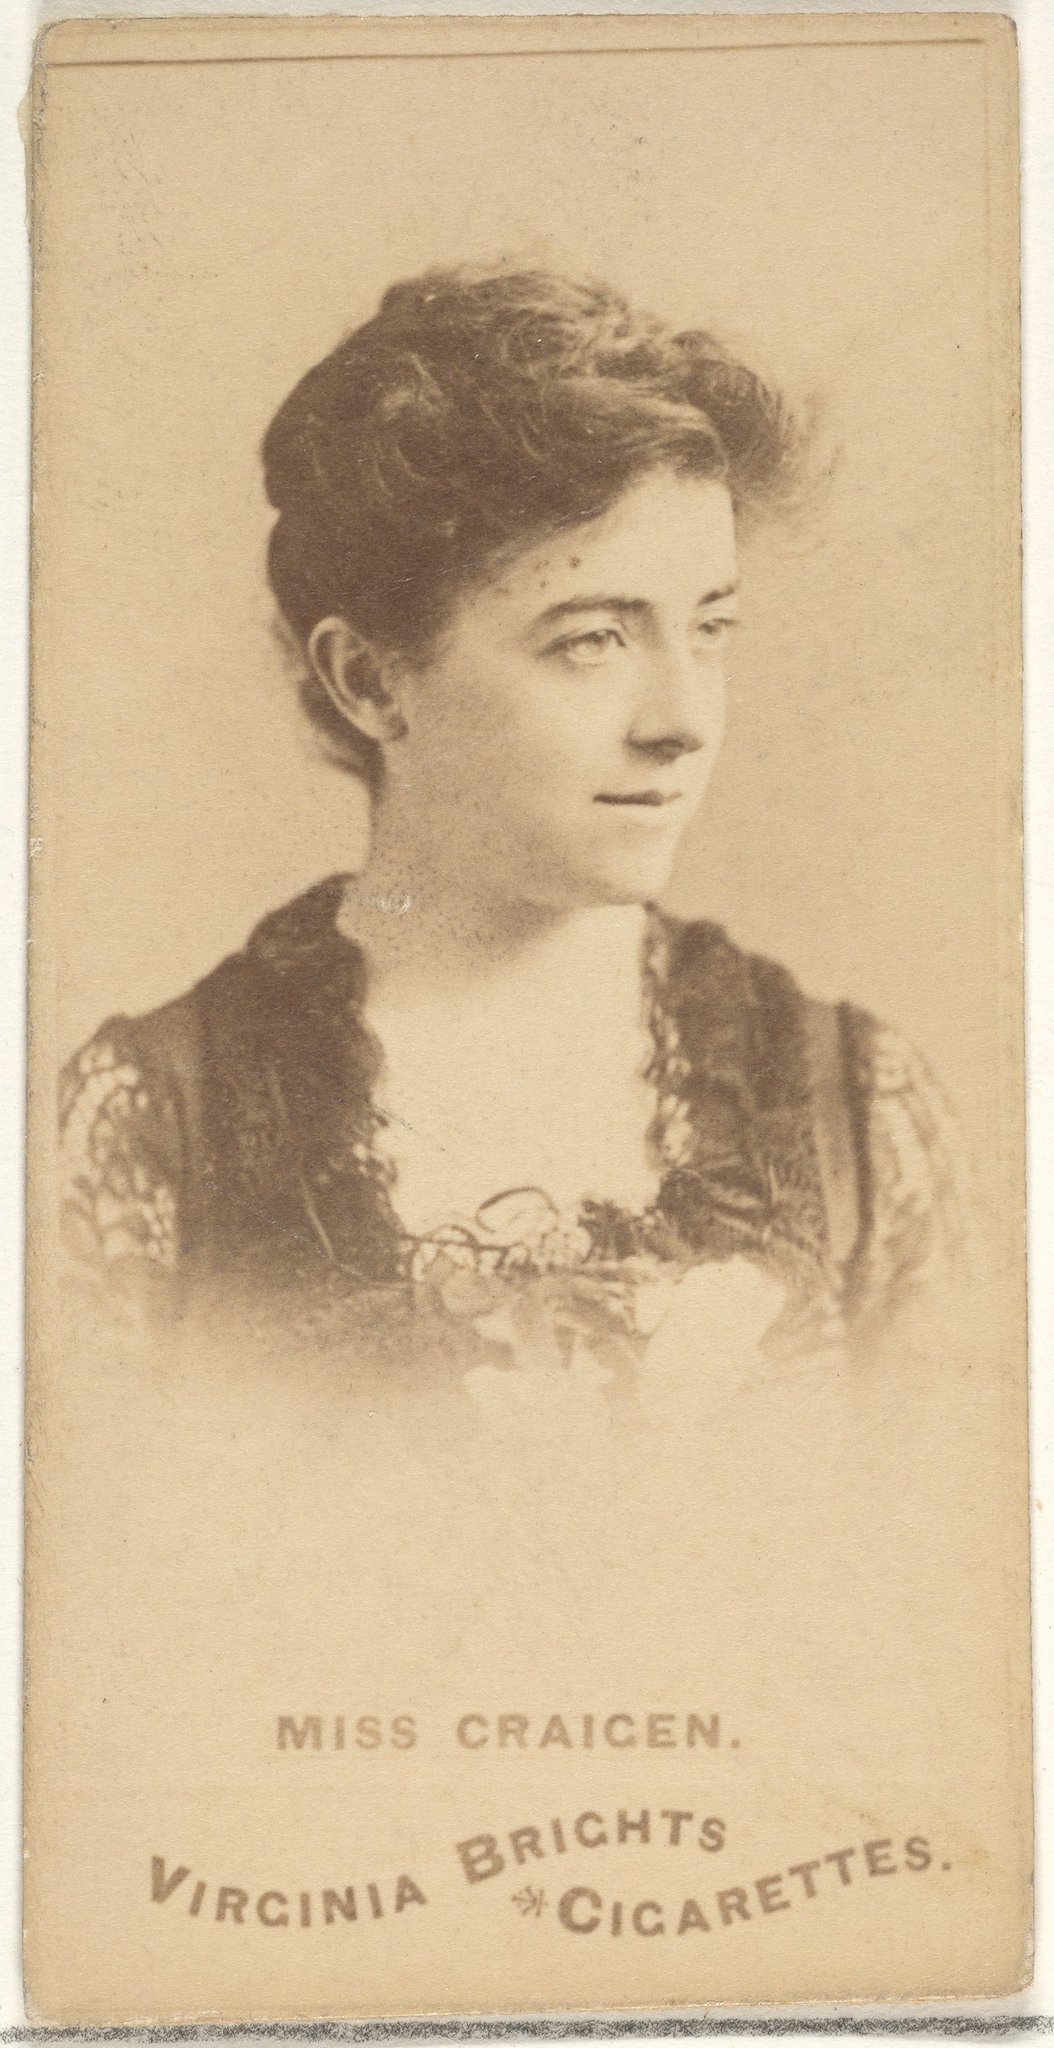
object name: photograph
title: Miss Craigen, from the Actors and Actresses series (N45, Type 1) for Virginia Brights Cigarettes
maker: allen & ginter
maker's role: publisher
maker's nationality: american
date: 1888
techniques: albumen silver print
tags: portraits,women,actresses